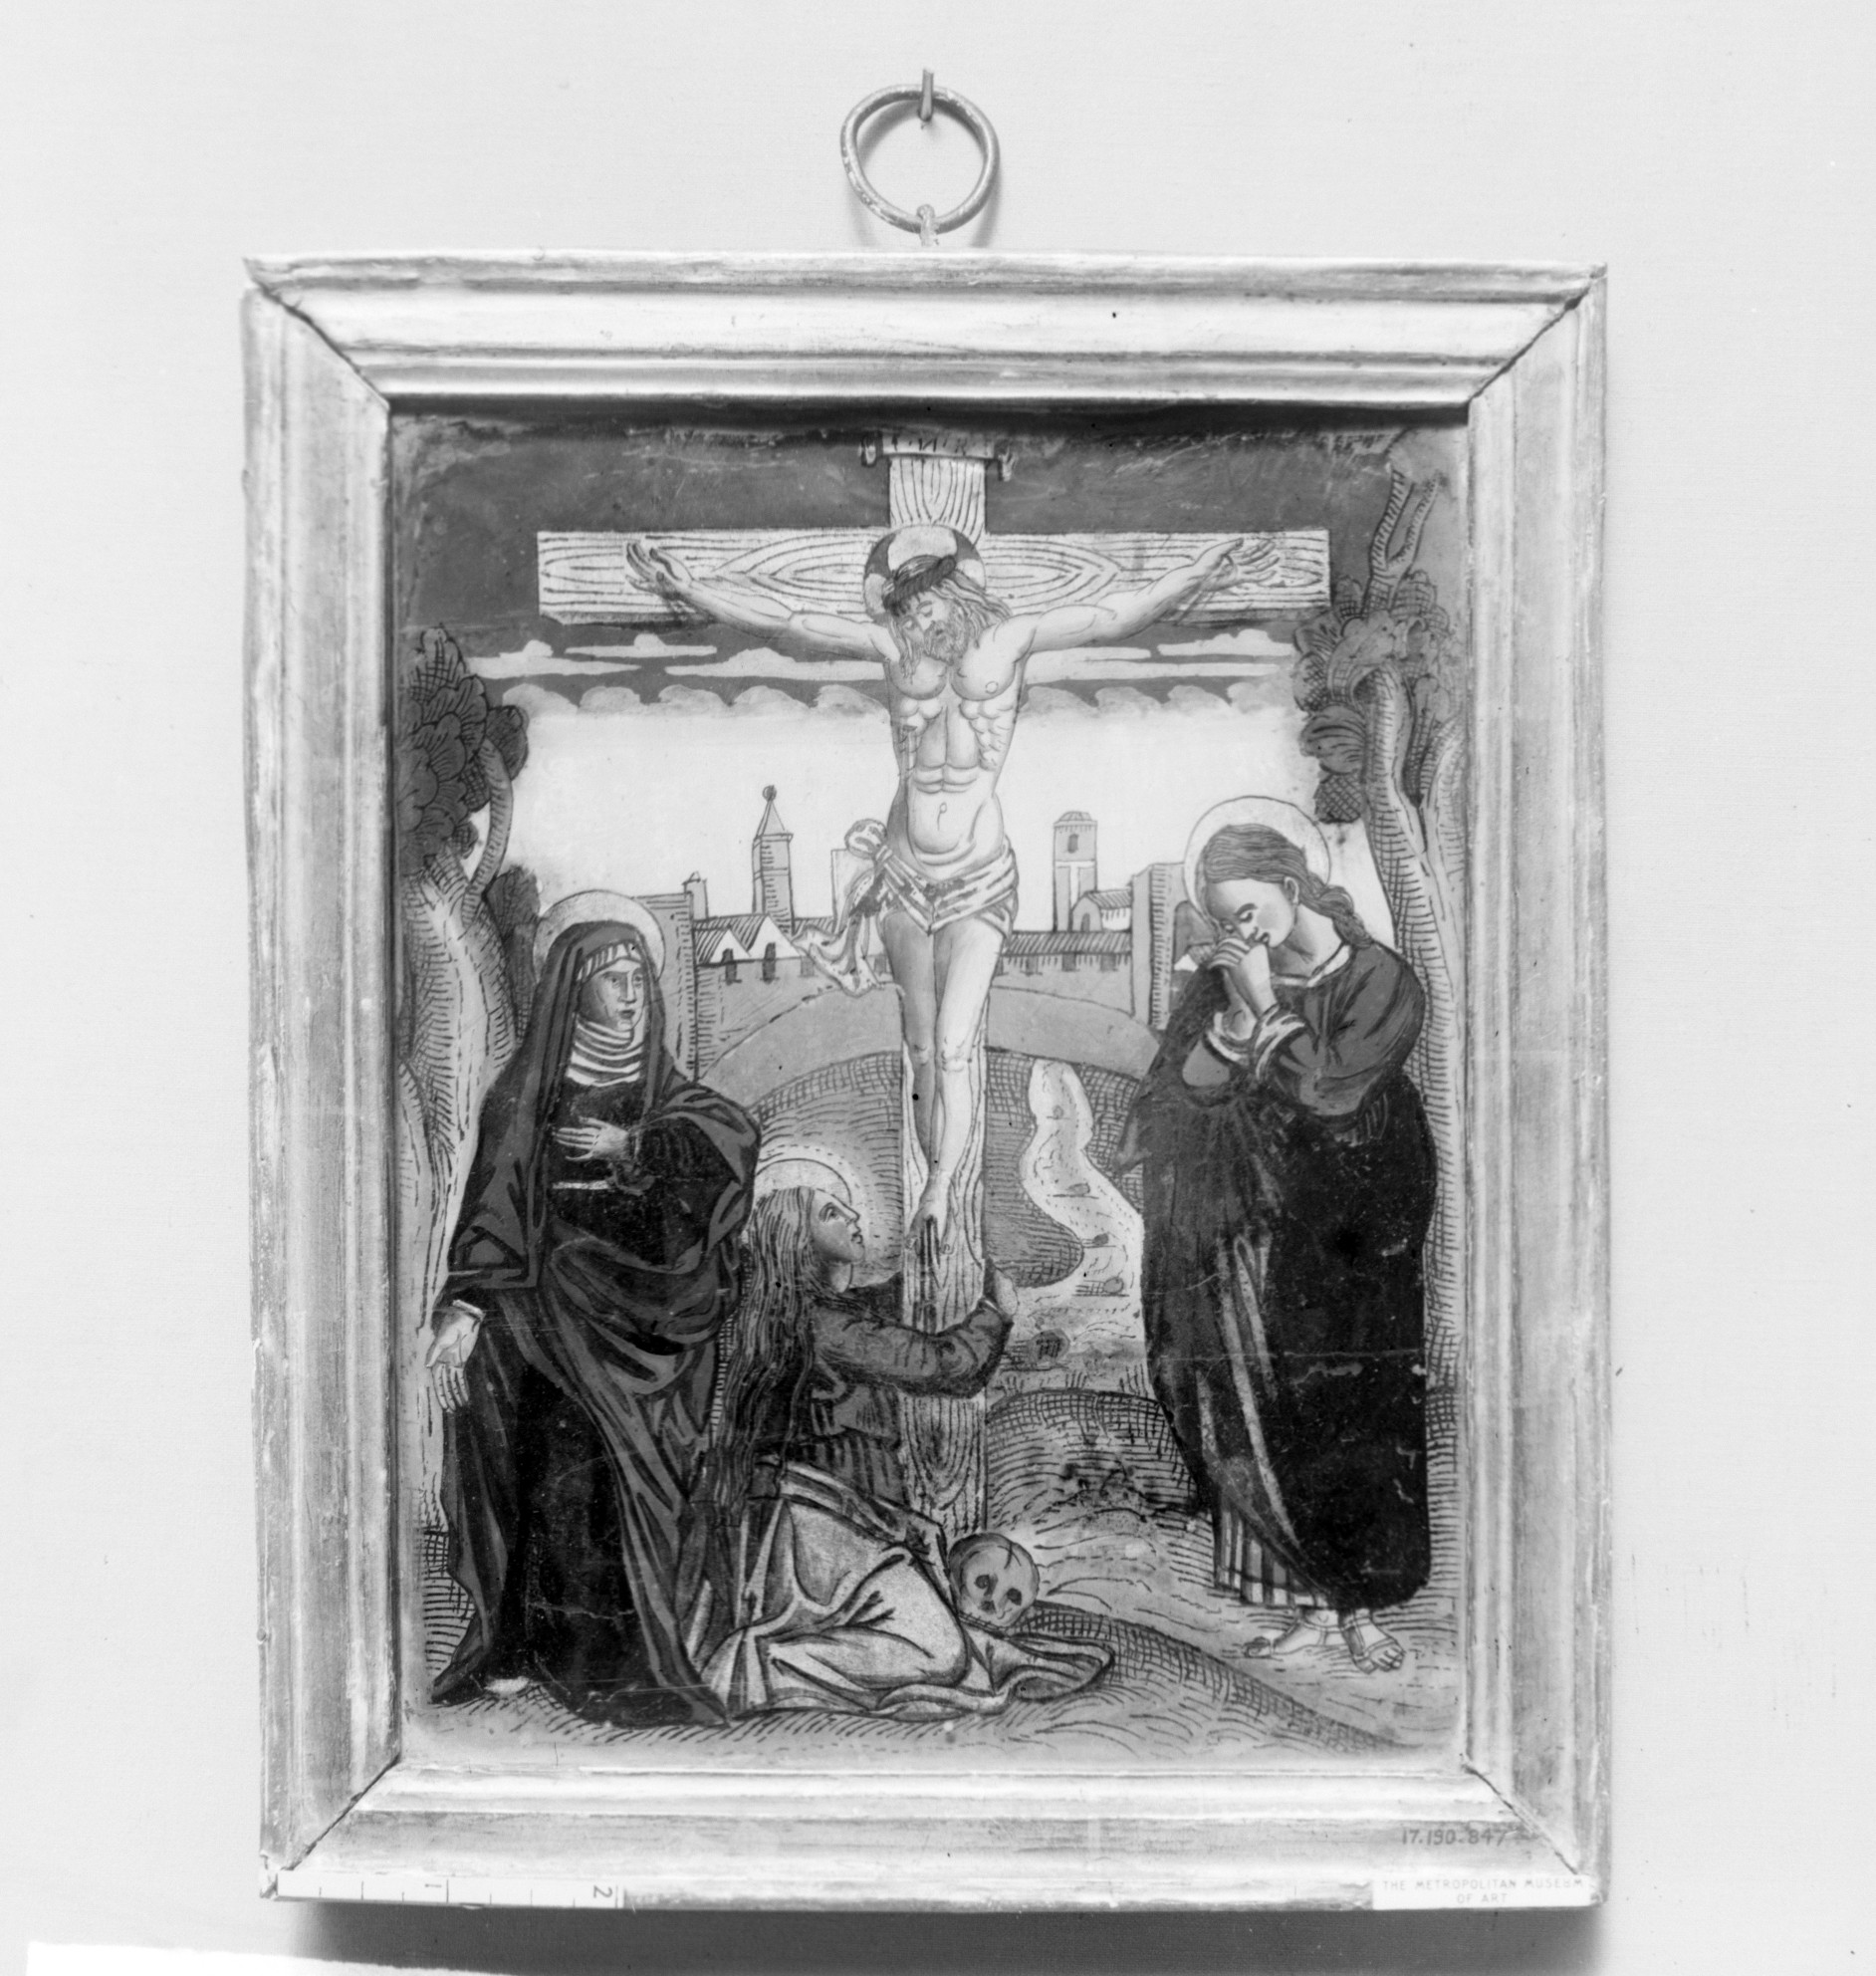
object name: panel or plaque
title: Crucifixion with three Marys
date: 1501-1600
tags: virgin mary,jesus,crucifixion